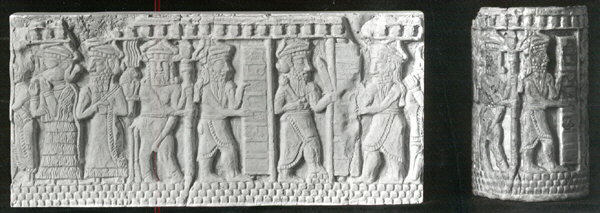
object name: relief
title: Cylinder with a ritual scene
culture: iranian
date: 2000-1668 BCE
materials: alabaster, gypsum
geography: iran